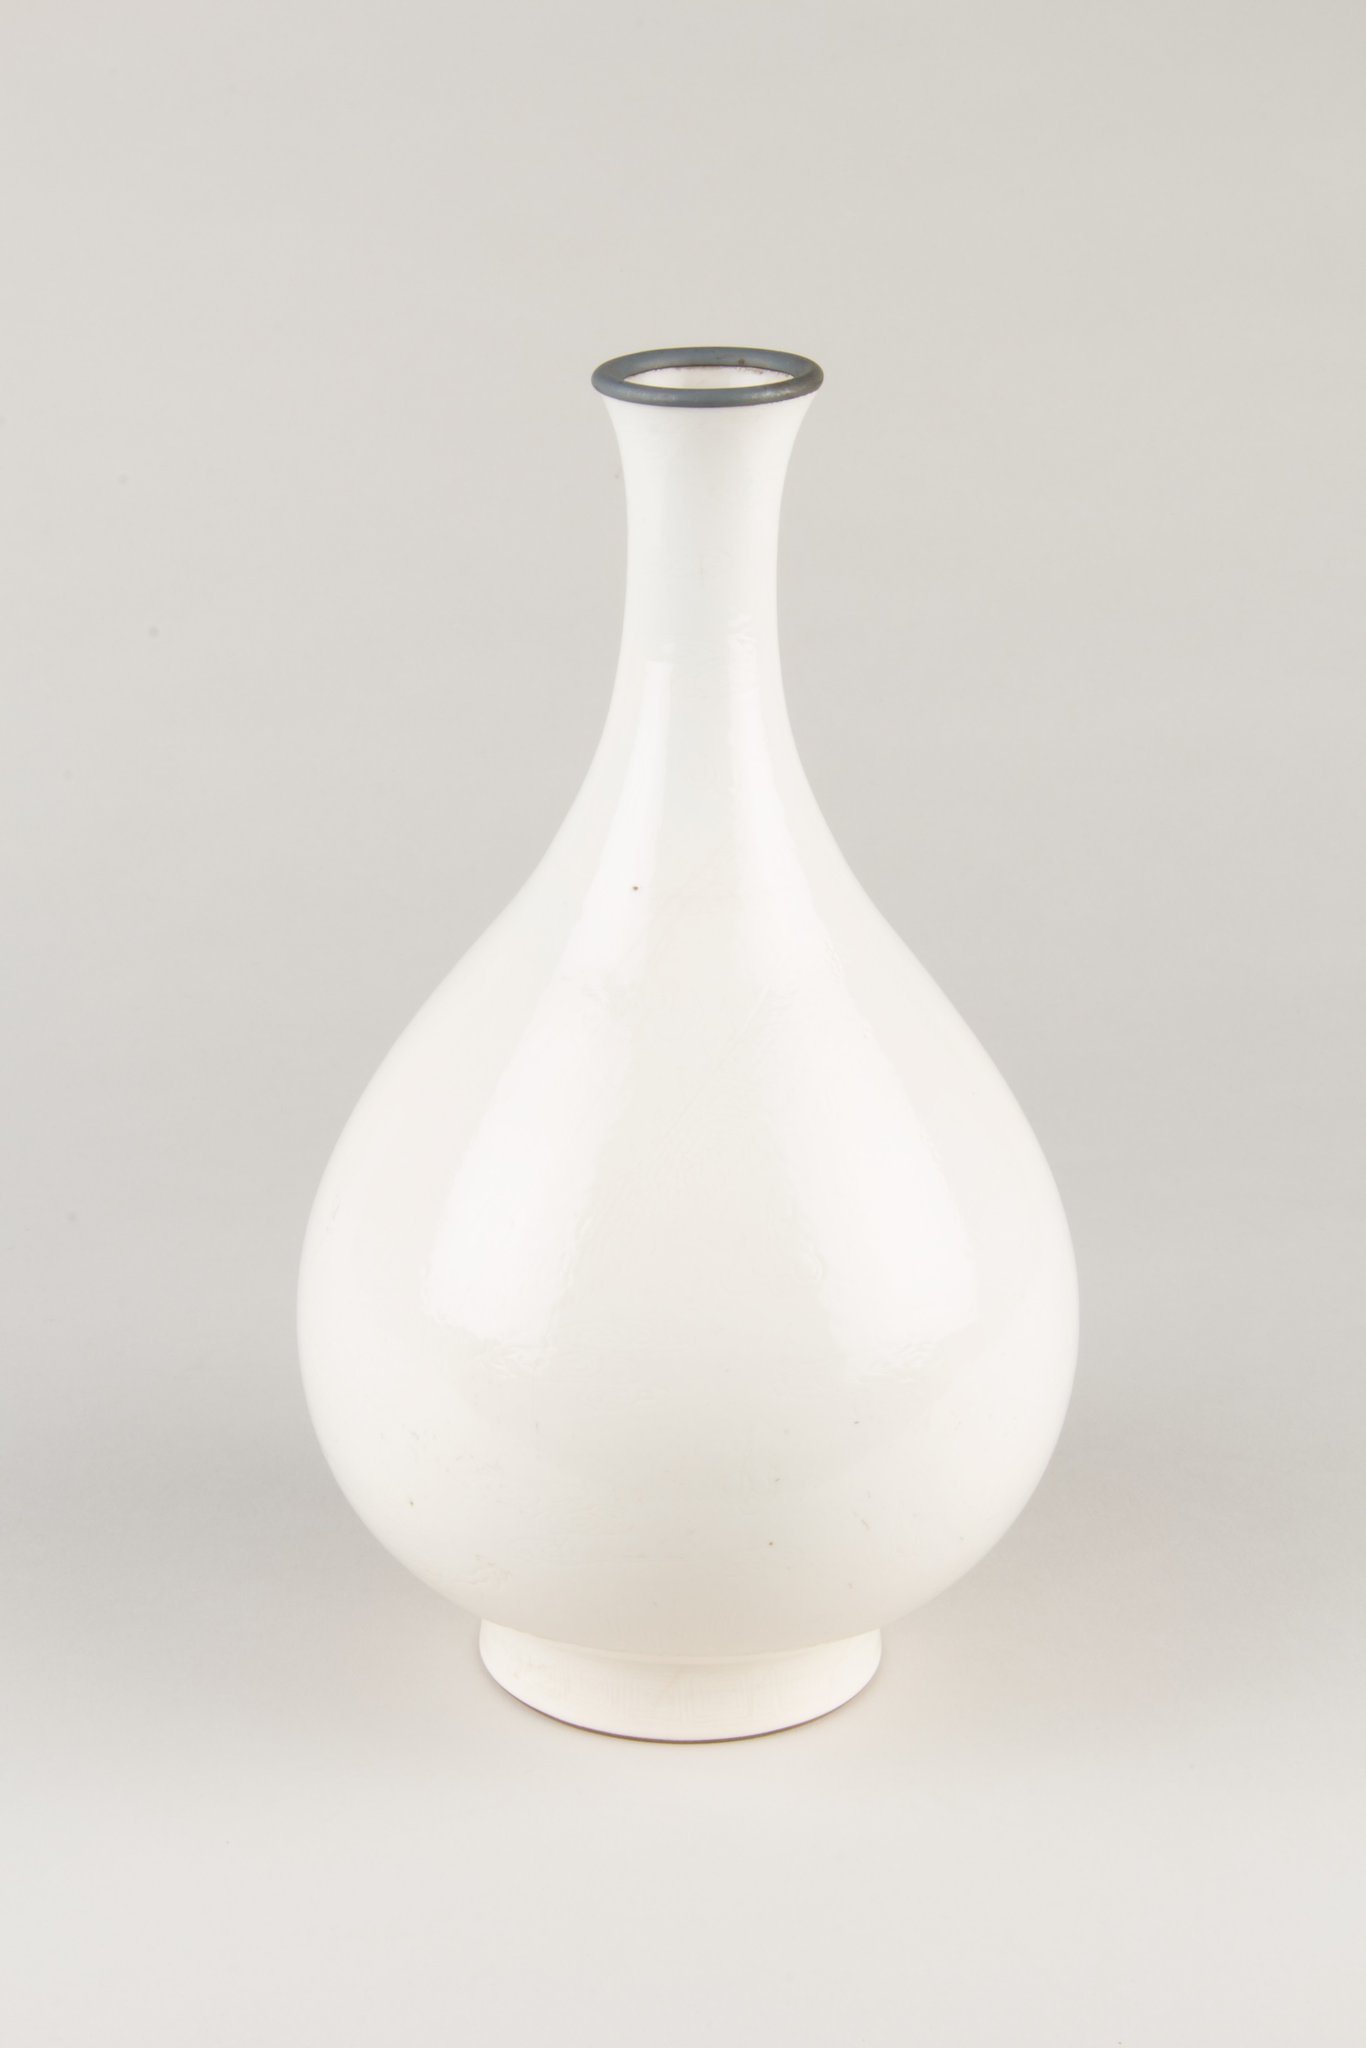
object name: bottle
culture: chinese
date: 1723-1735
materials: porcelain